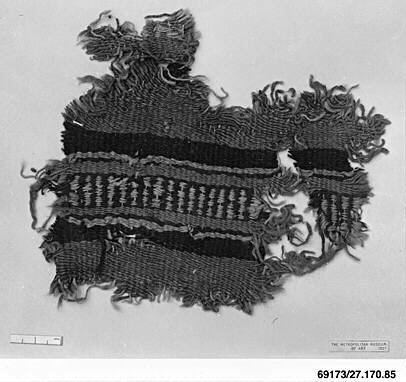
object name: textile fragment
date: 1001-1200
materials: wool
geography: egypt